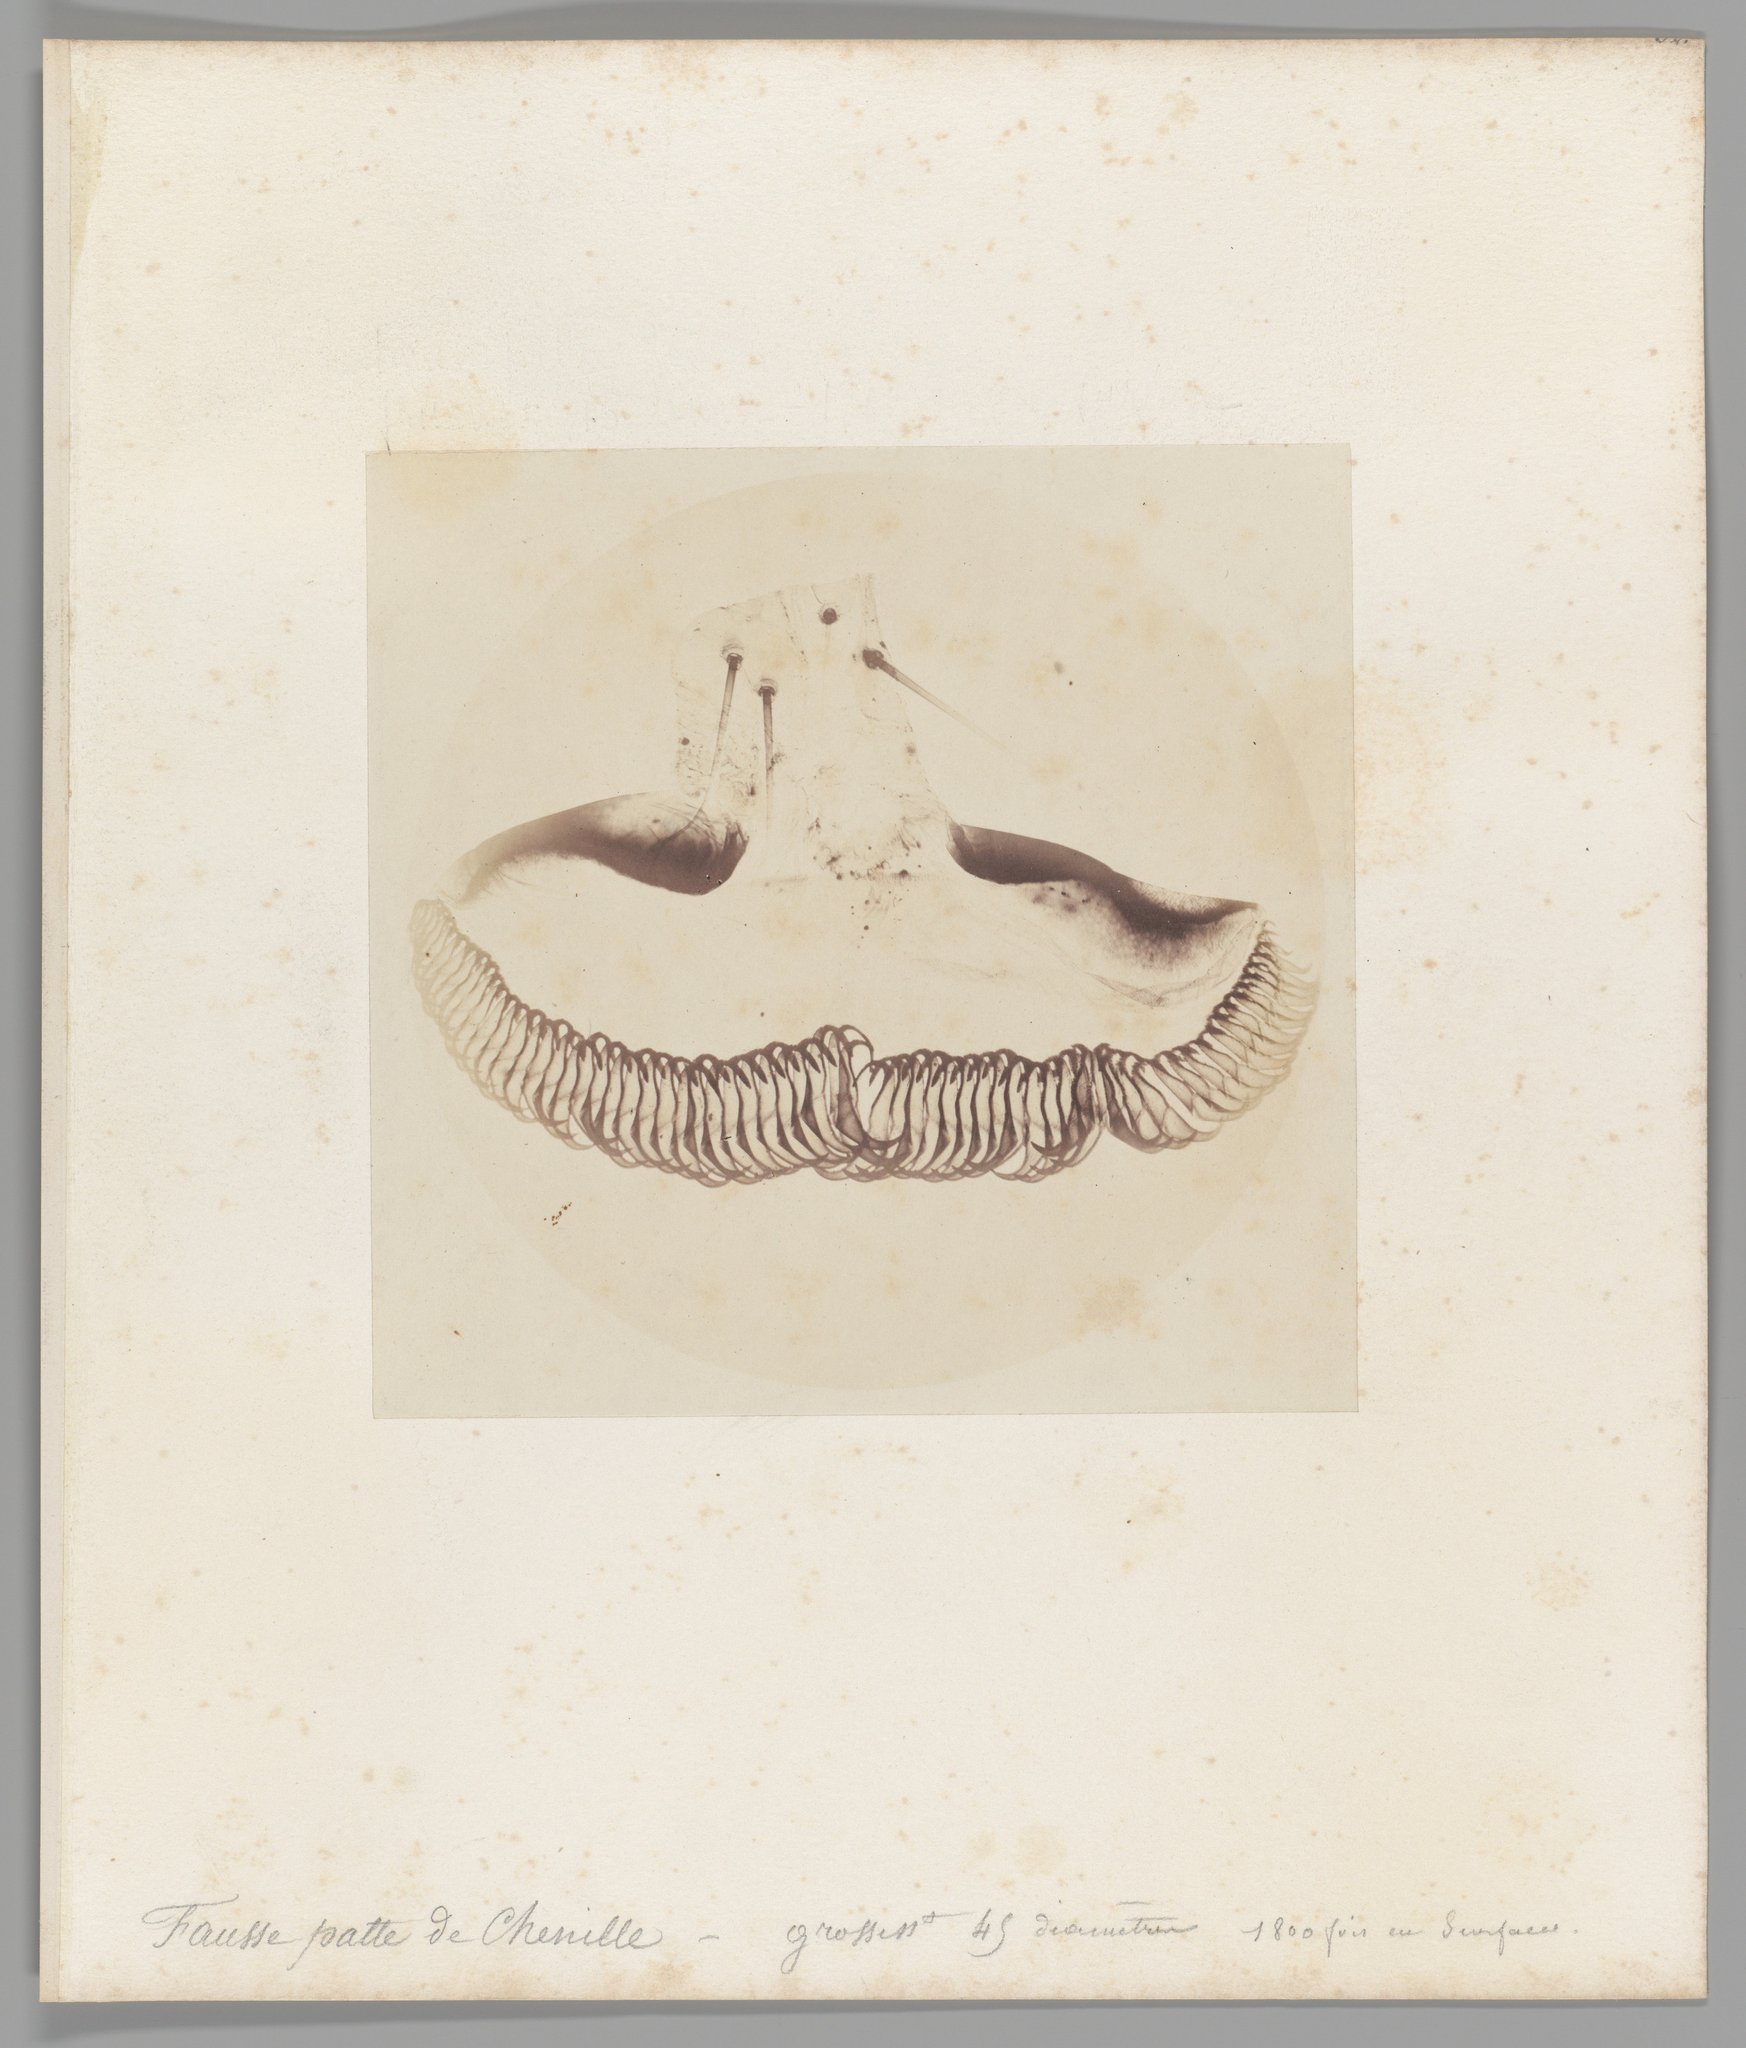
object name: photograph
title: [Untitled]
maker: auguste-adolphe bertsch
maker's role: artist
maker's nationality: french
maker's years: 1813-1871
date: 1853-1857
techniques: salted paper print